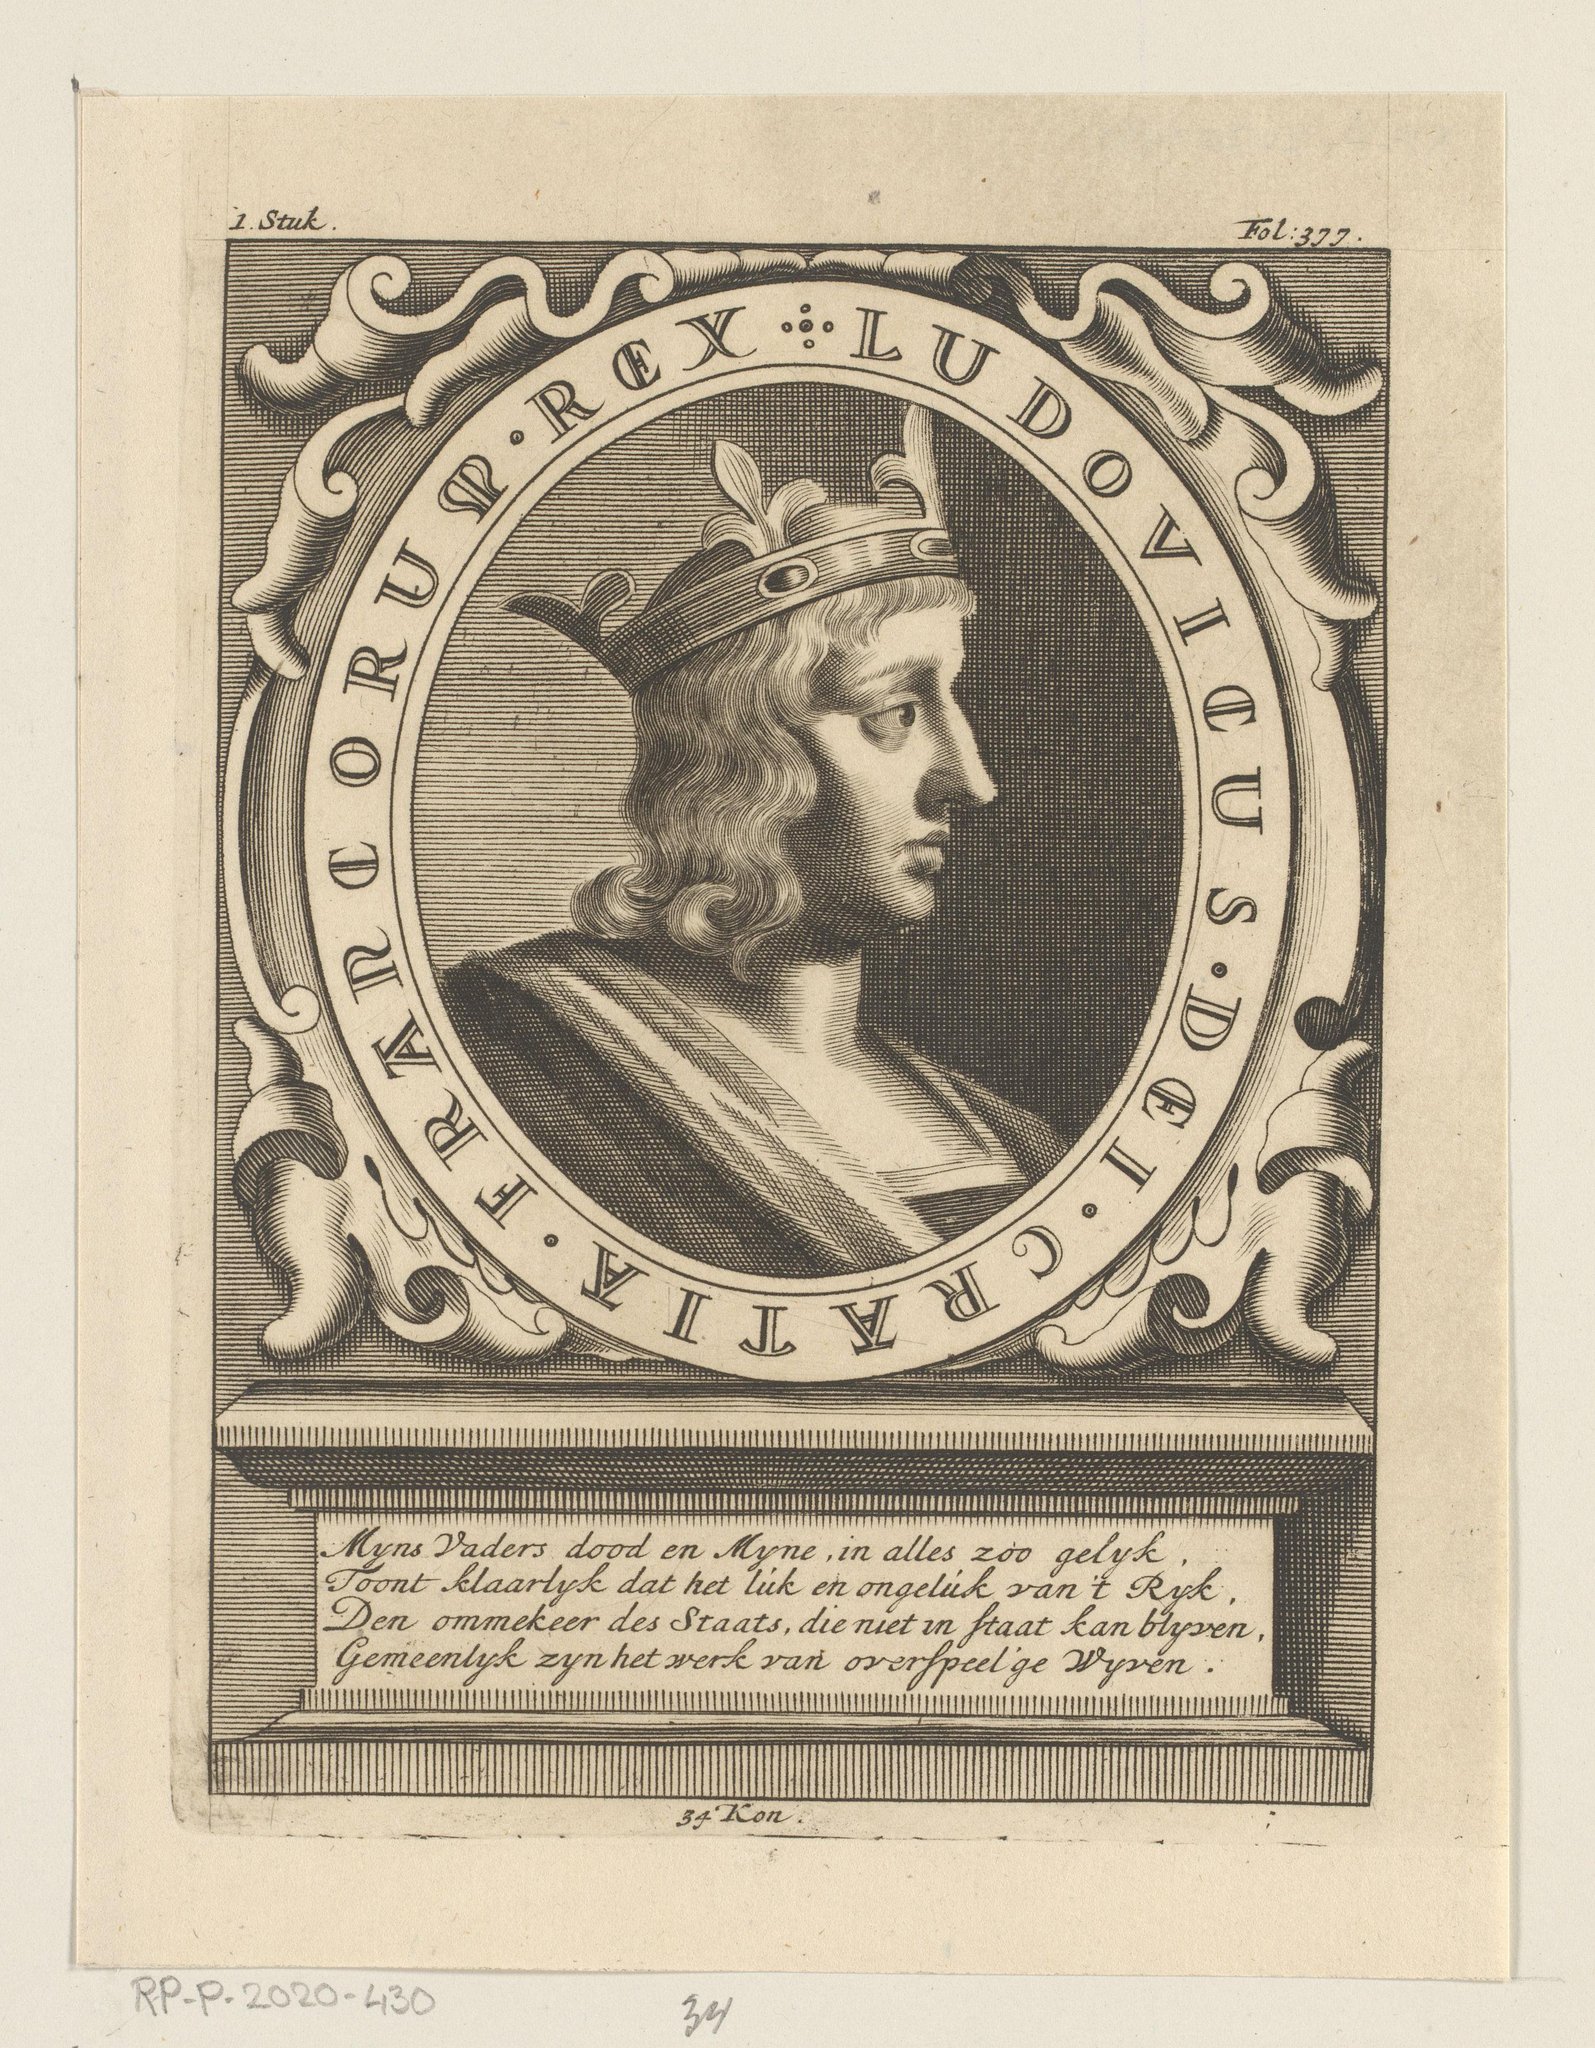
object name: print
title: Ludovicus dei gratia Francorum rex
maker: Anonymous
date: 1685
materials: paper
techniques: engraving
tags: historical persons, ruler, sovereign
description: Prent ook gebruikt in: Eudes de Mézeray, François. Chronyk van Vrankryk. 6 dln. Amsterdam: Jan Bouman en Timotheum ten Hoorn, 1685, dl.1.